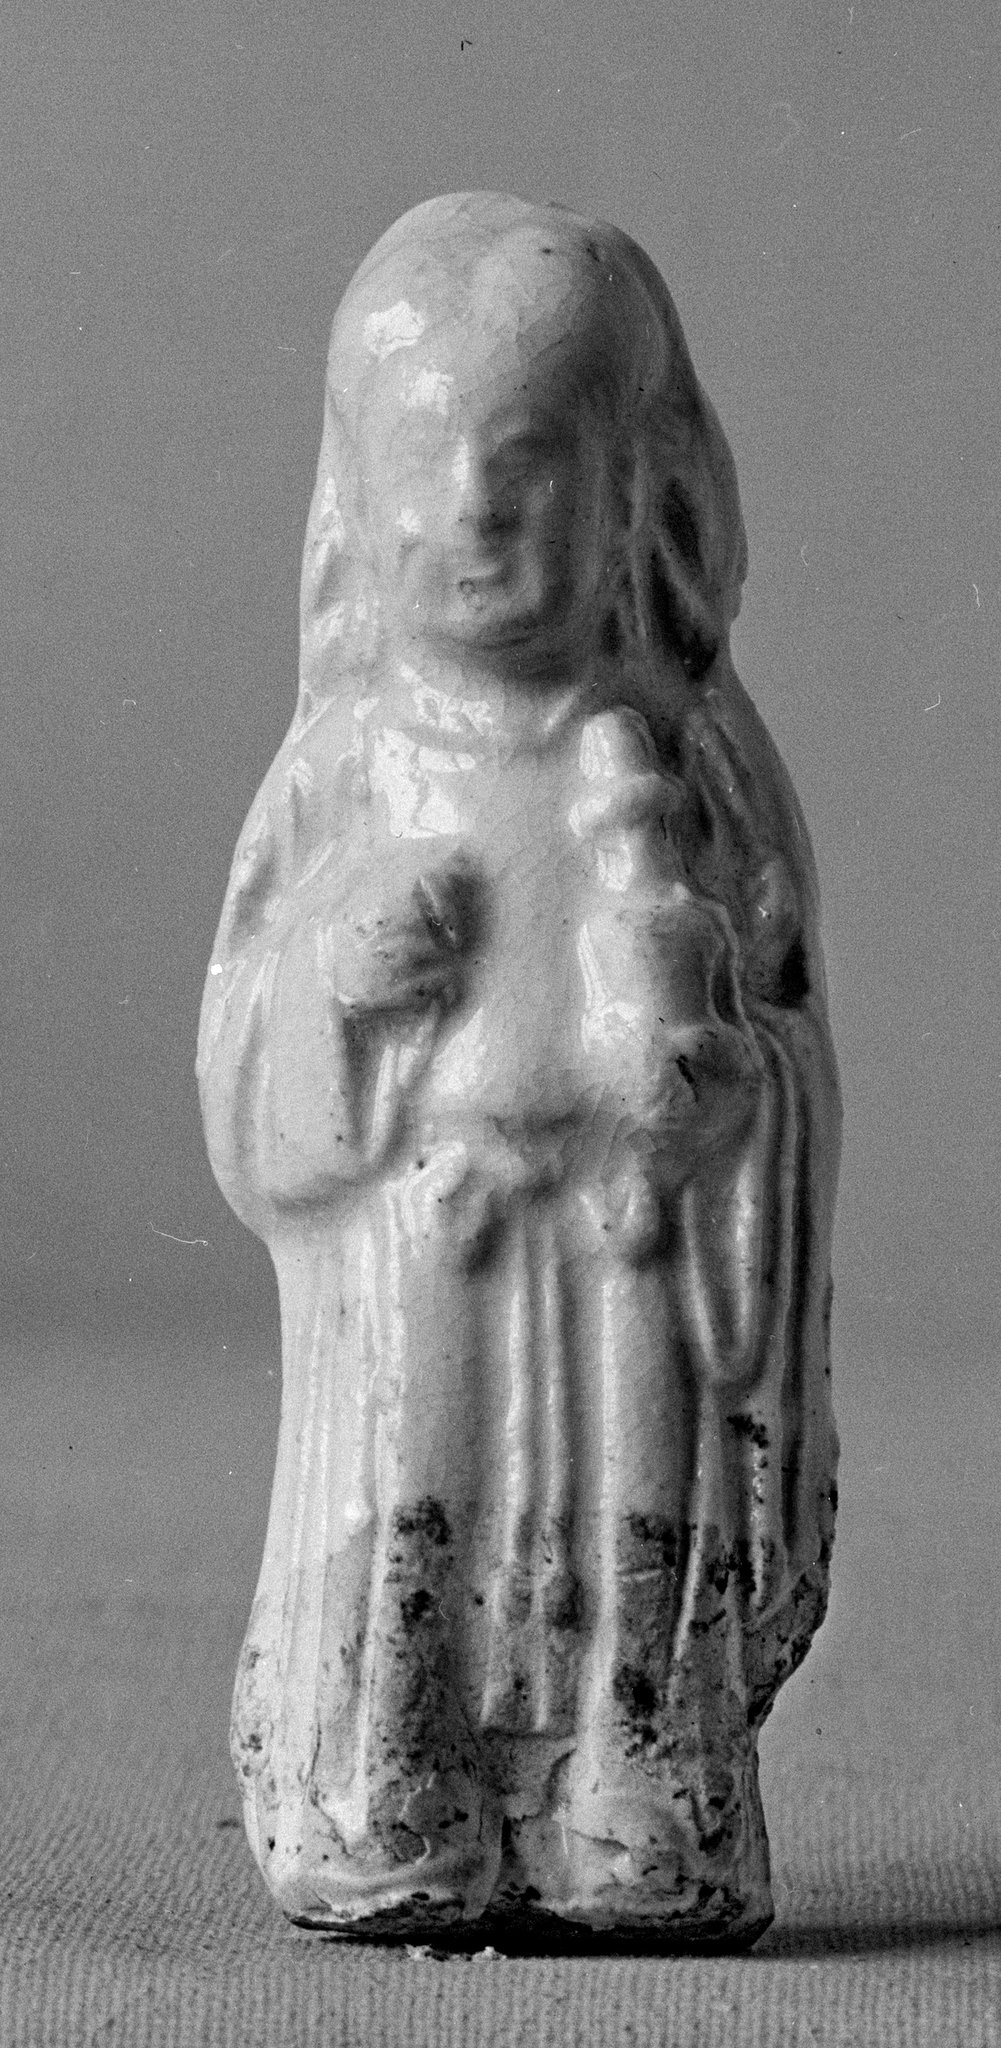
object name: figure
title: Standing Figure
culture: chinese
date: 960-1279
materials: clay, glaze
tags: women